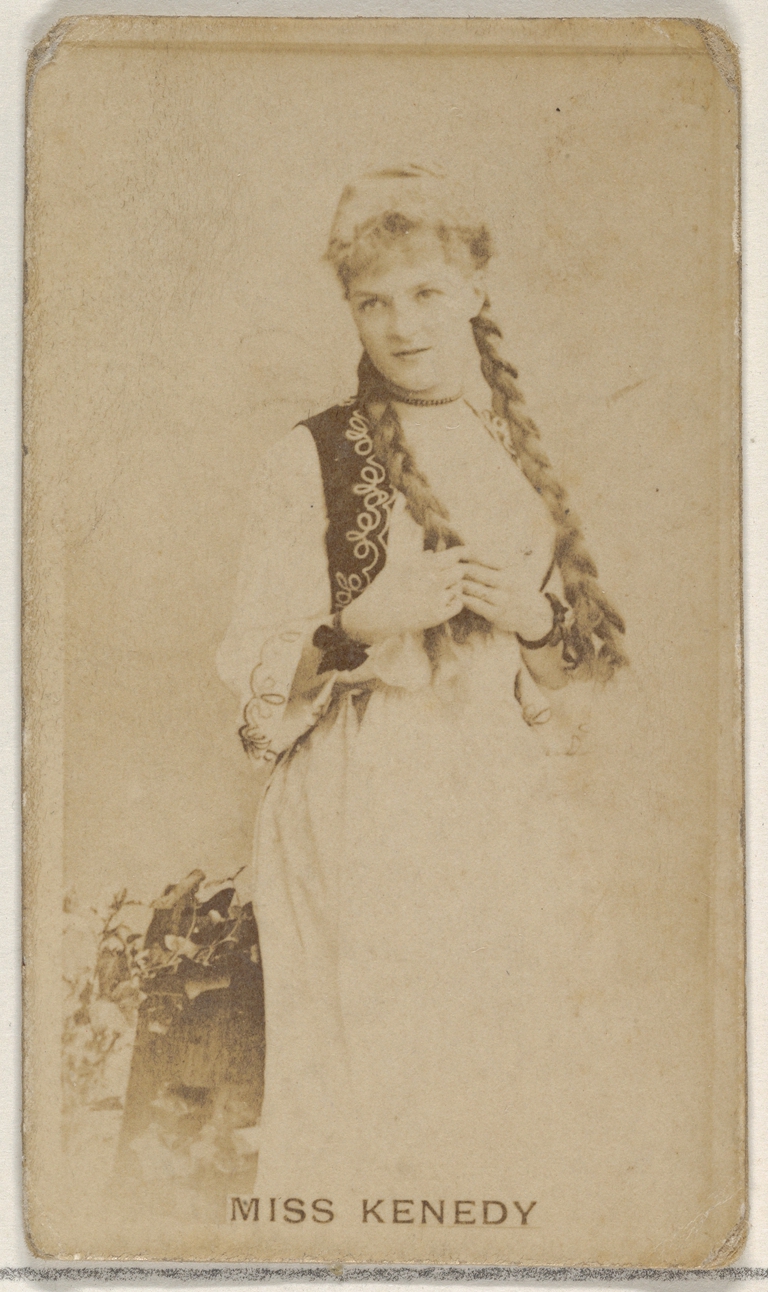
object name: photograph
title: Miss Kenedy, from the Actors and Actresses series (N45, Type 8) for Virginia Brights Cigarettes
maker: allen & ginter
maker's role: publisher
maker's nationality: american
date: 1888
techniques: albumen silver print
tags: portraits,women,actresses